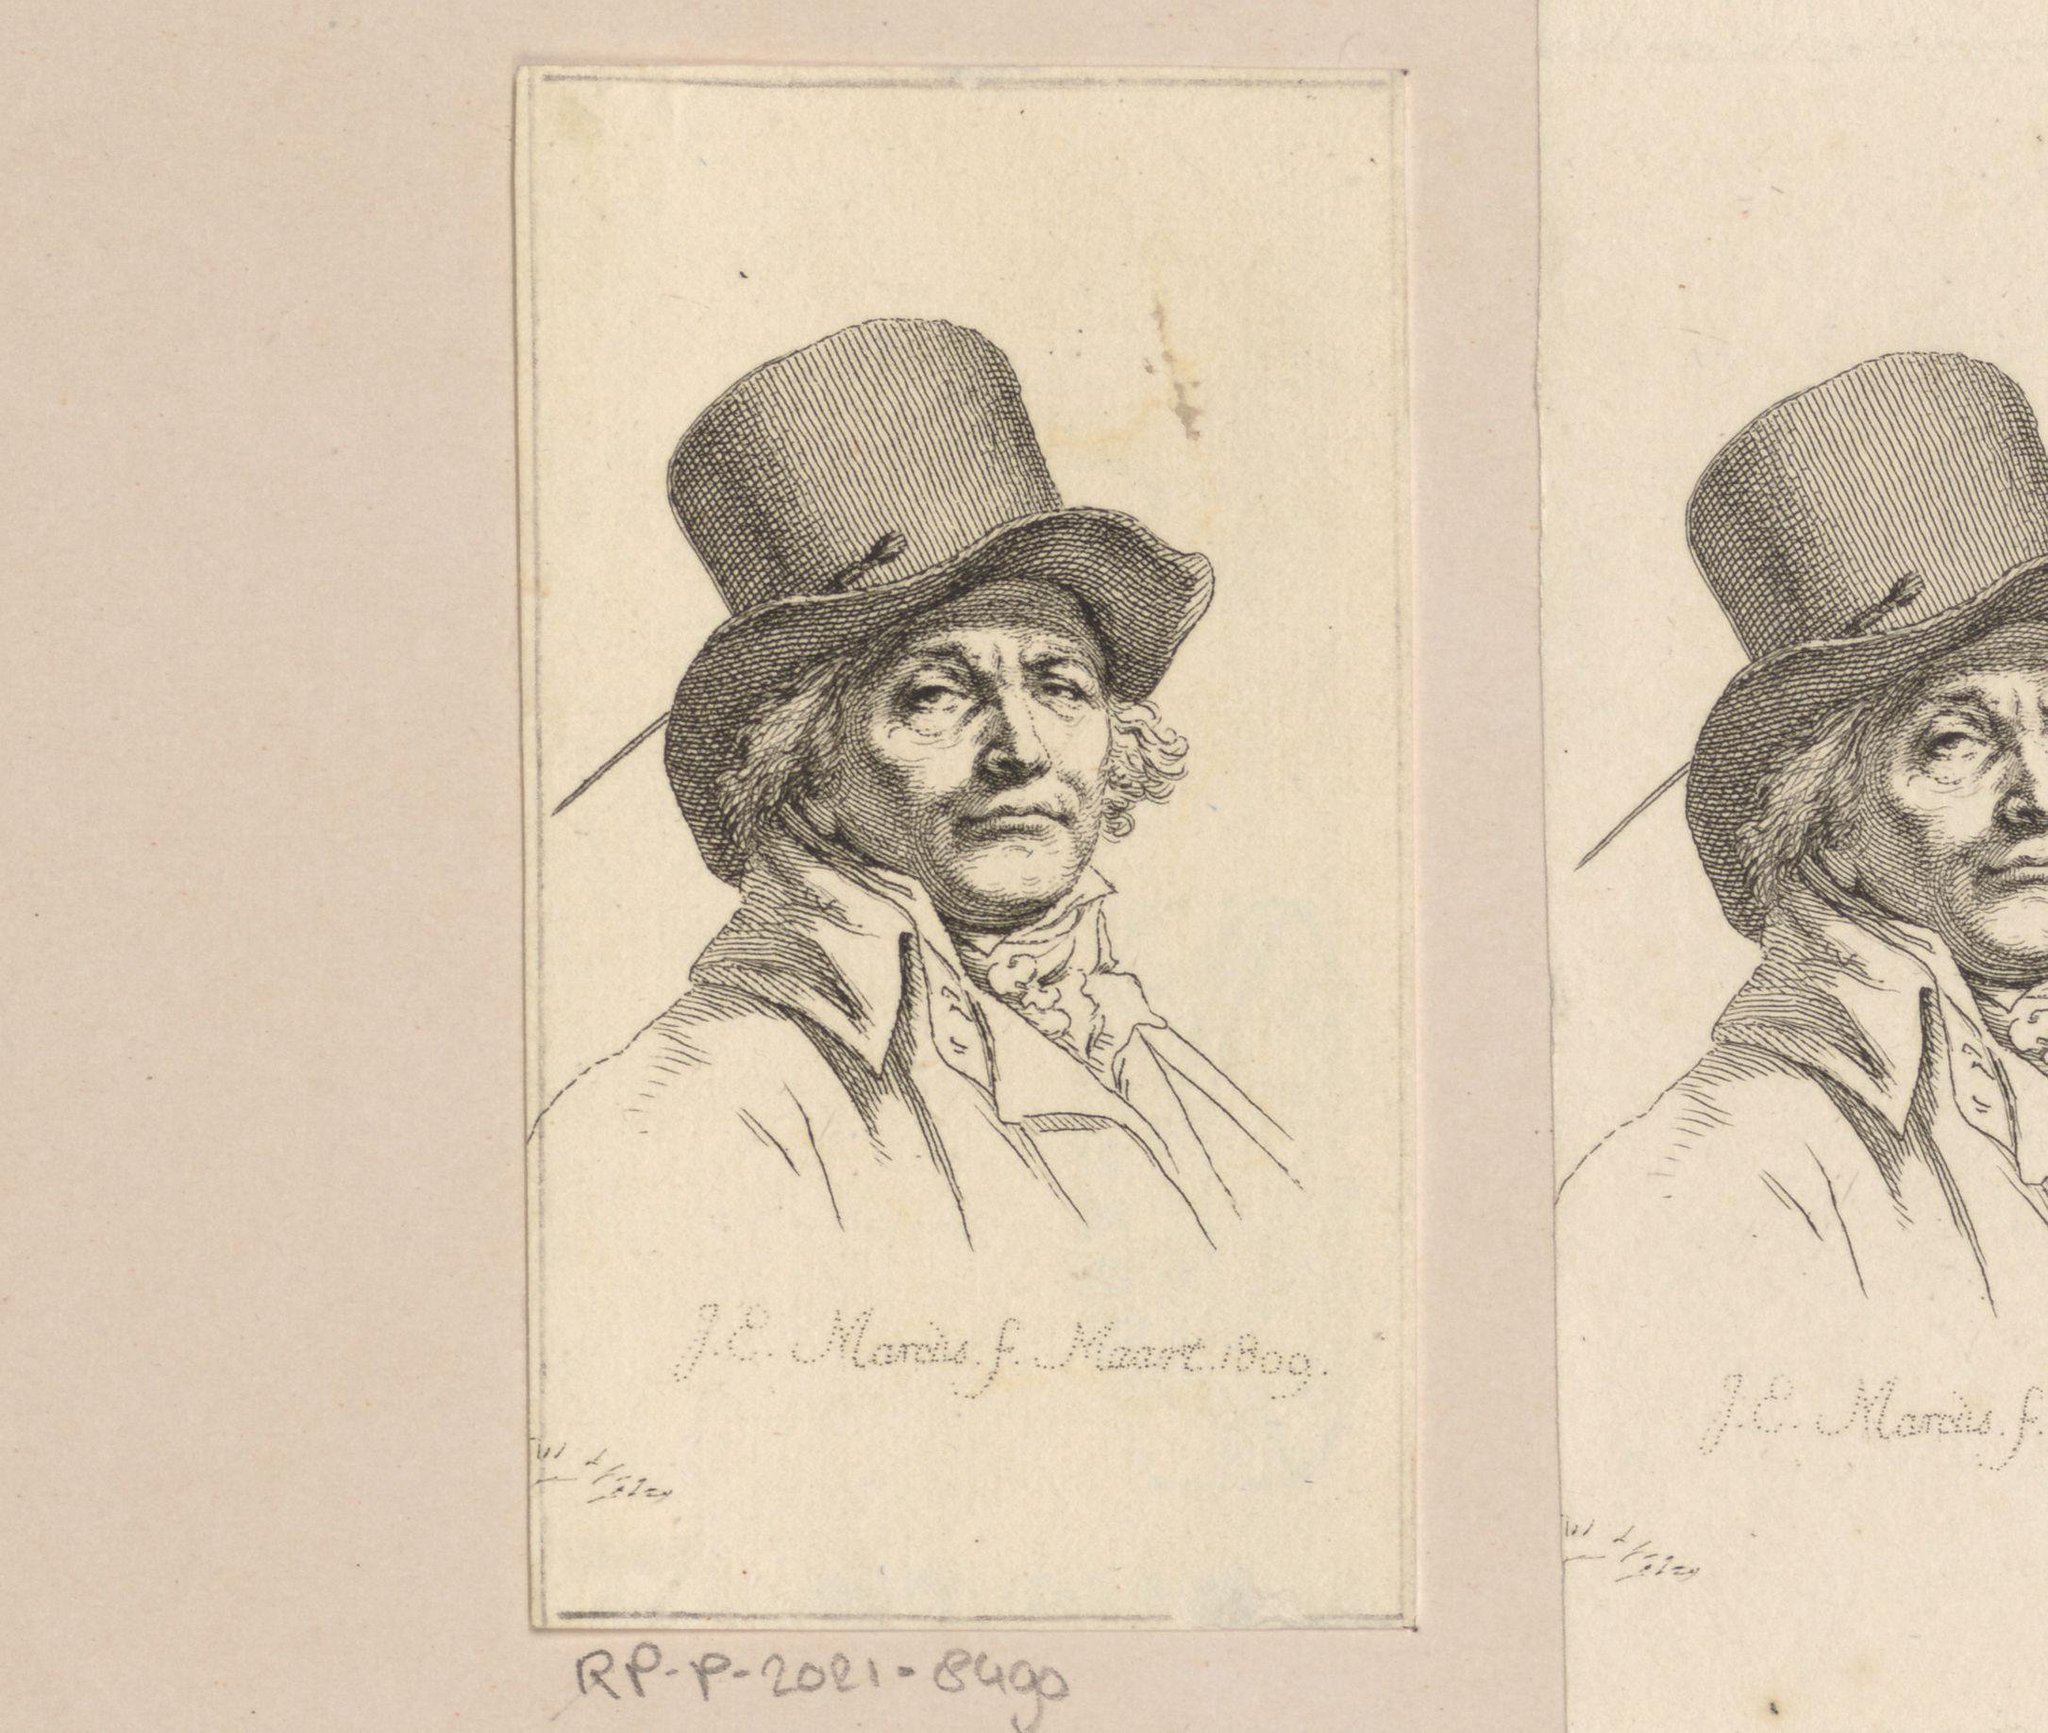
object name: print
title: Studie-prentwerk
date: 1803-1809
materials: paper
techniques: etching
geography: amsterdam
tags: utrecht, amsterdam, draughtsman, gabriël van rooyen, historical persons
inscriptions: collector's mark: Lugt 924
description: Portret geknipt uit grotere prent met vier afbeeldingen. Serie voor het eerst uitgegeven door Jacob Ernst Marcus onder de titel Studiebeelden en Fragmenten. Amsterdam: ca. 1816. Later heruitgegeven als: Marcus, Jacob Ernst. Etudes gravées, Amsterdam: Simon de Grebber, [1826].